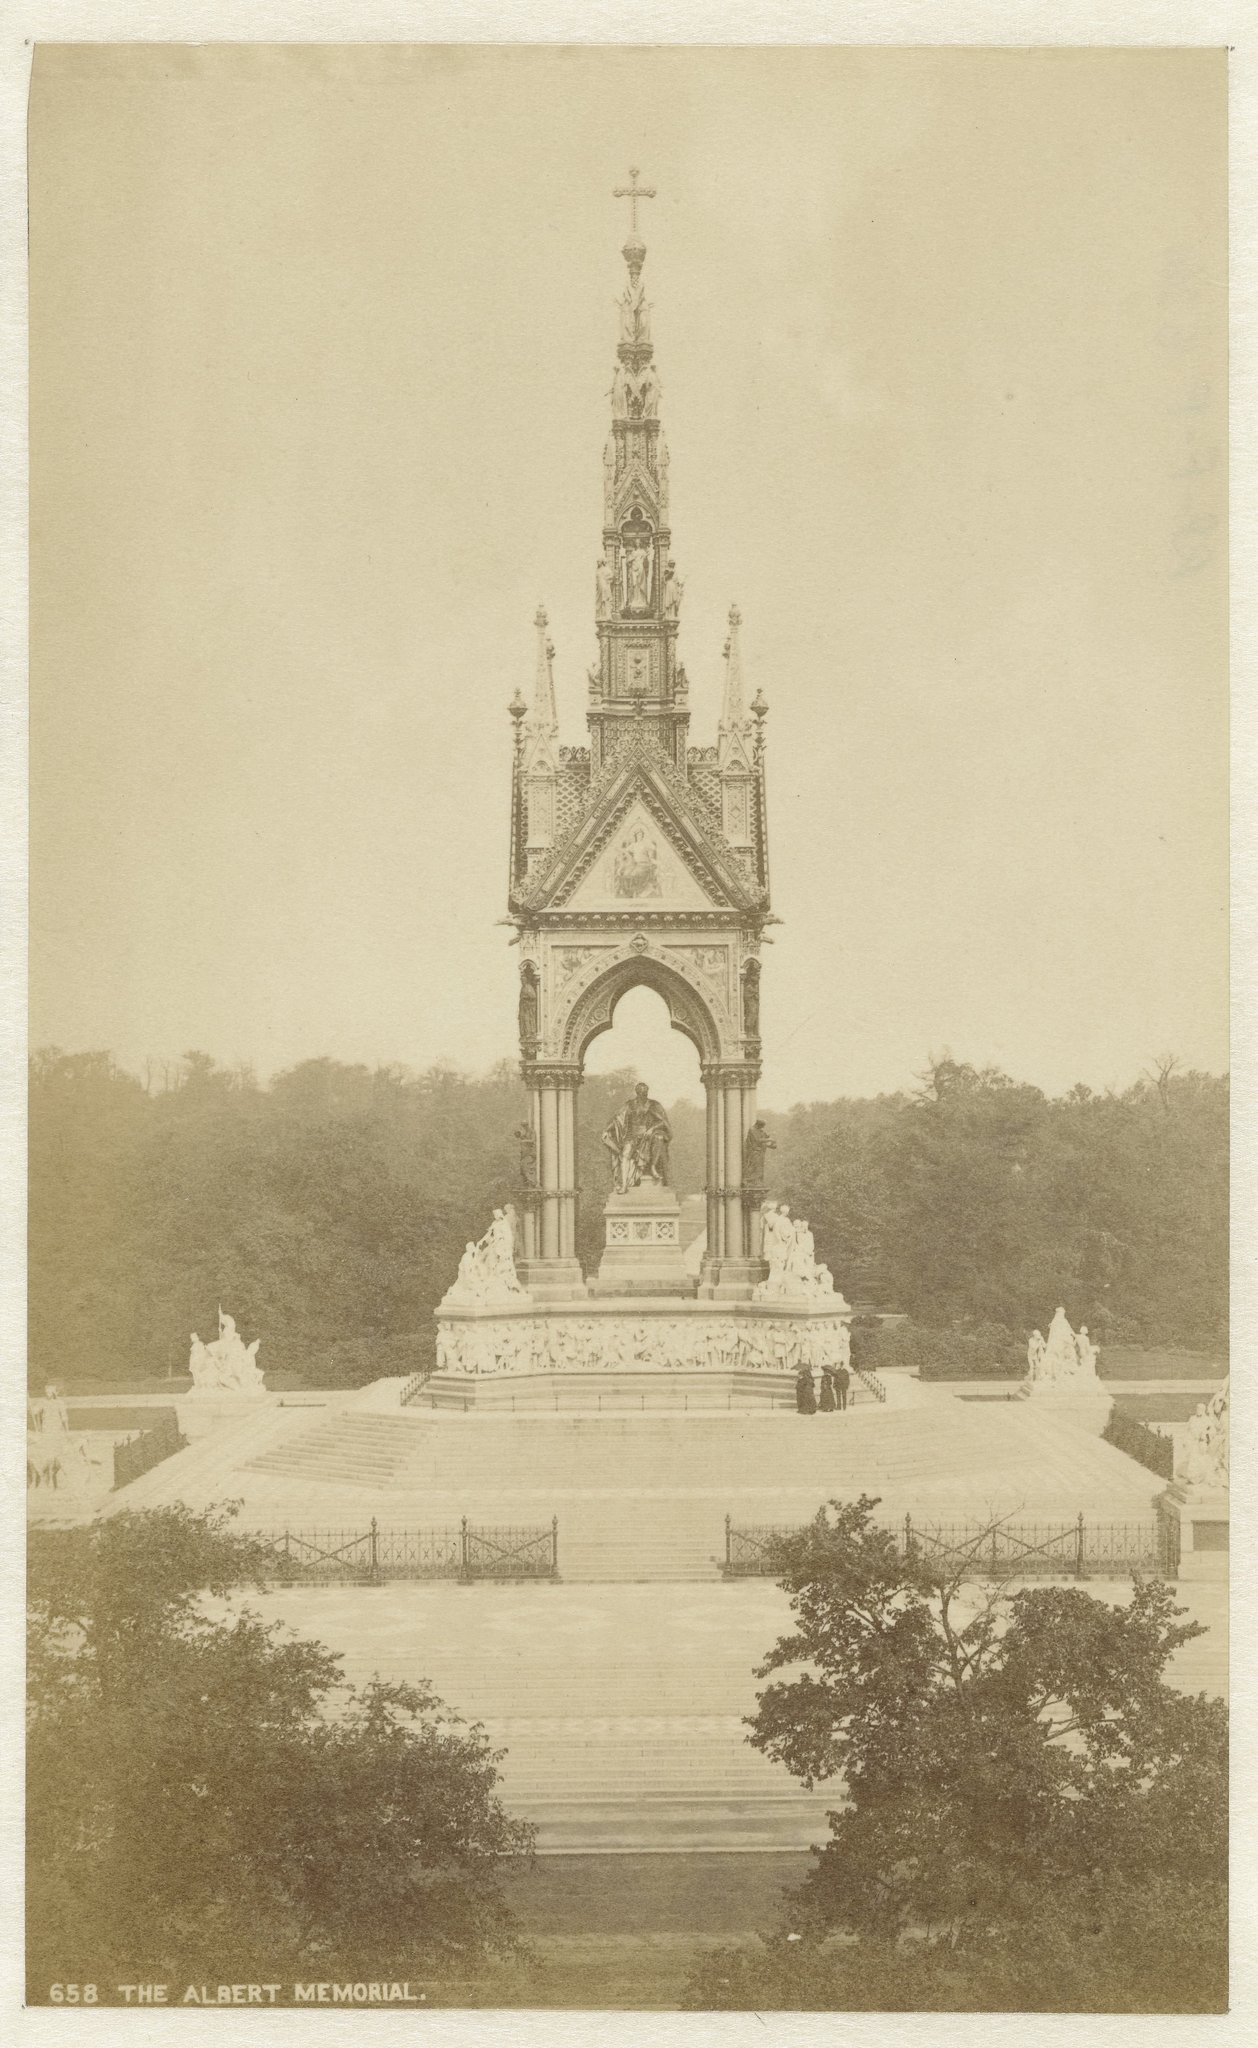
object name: photograph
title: Gedenkteken voor prins Albert in Kensington Gardens, Londen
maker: Anonymous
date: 1876-1880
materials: paper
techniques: albumen print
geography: kensington gardens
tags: albert (prins van saksen-coburg en gotha), monument, statue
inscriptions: number: ‘658’